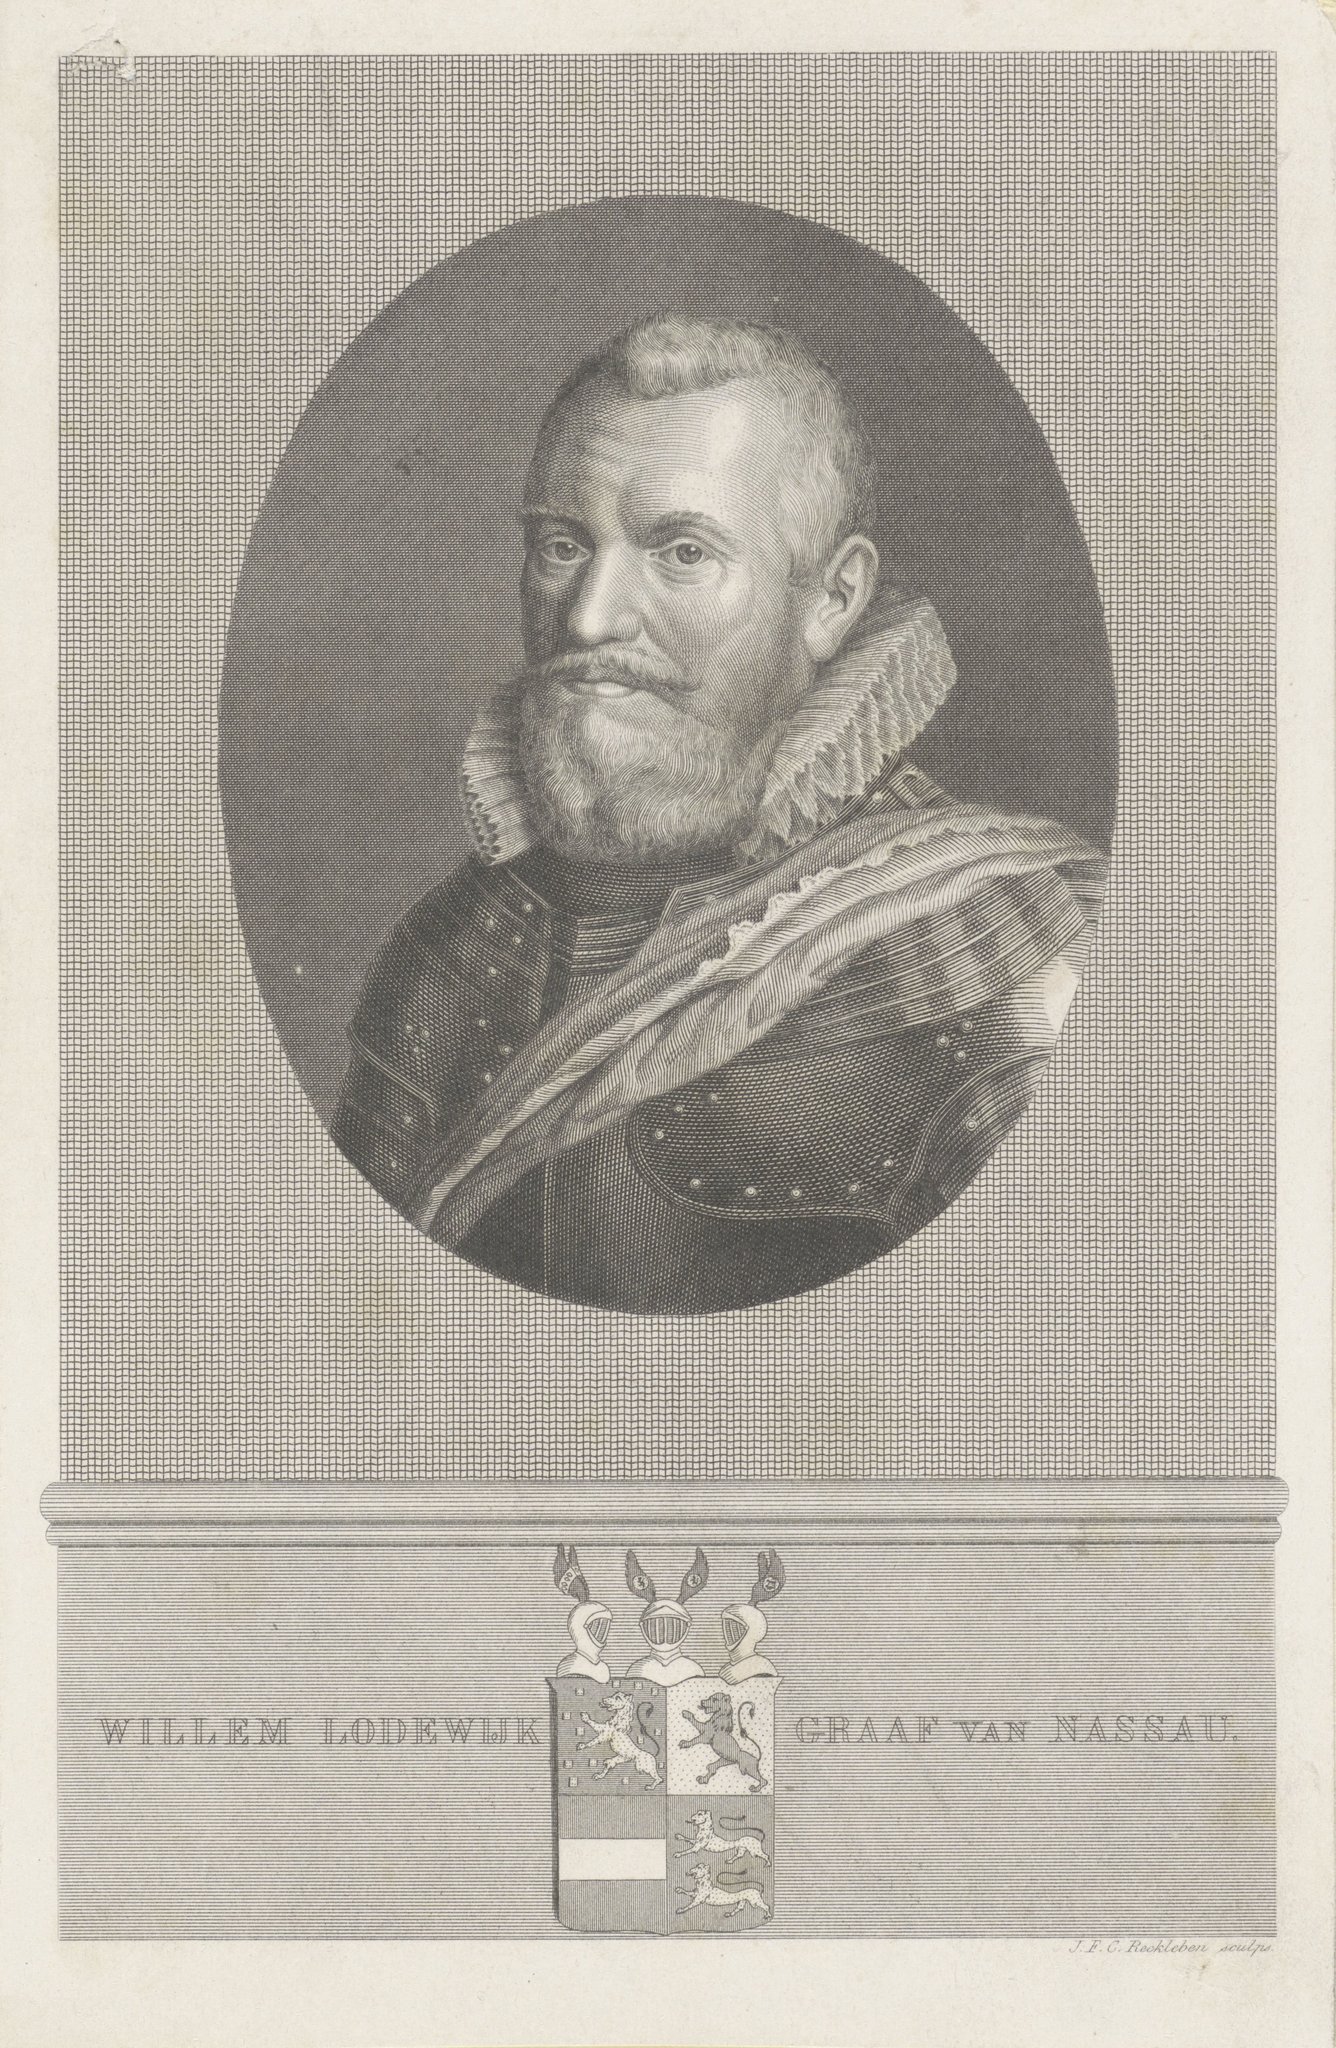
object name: book illustration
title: Portret van Willem Lodewijk, graaf van Nassau-Dillenburg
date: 1840-1884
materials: paper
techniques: engraving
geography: amsterdam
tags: willem lodewijk graaf van nassau-dillenburg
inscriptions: collector's mark: Lugt 2228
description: De hier vermelde titel verwijst naar de hoogst verkregen titel van de geportretteerde, niet per se naar de titel die de geportretteerde op deze voorstelling draagt. Prent uit: Arend, Johannes Pieter. Algemeene geschiedenis des vaderlands van de vroegste tijden tot op heden. Amsterdam: J.F. Schleijer, 1840-1884.